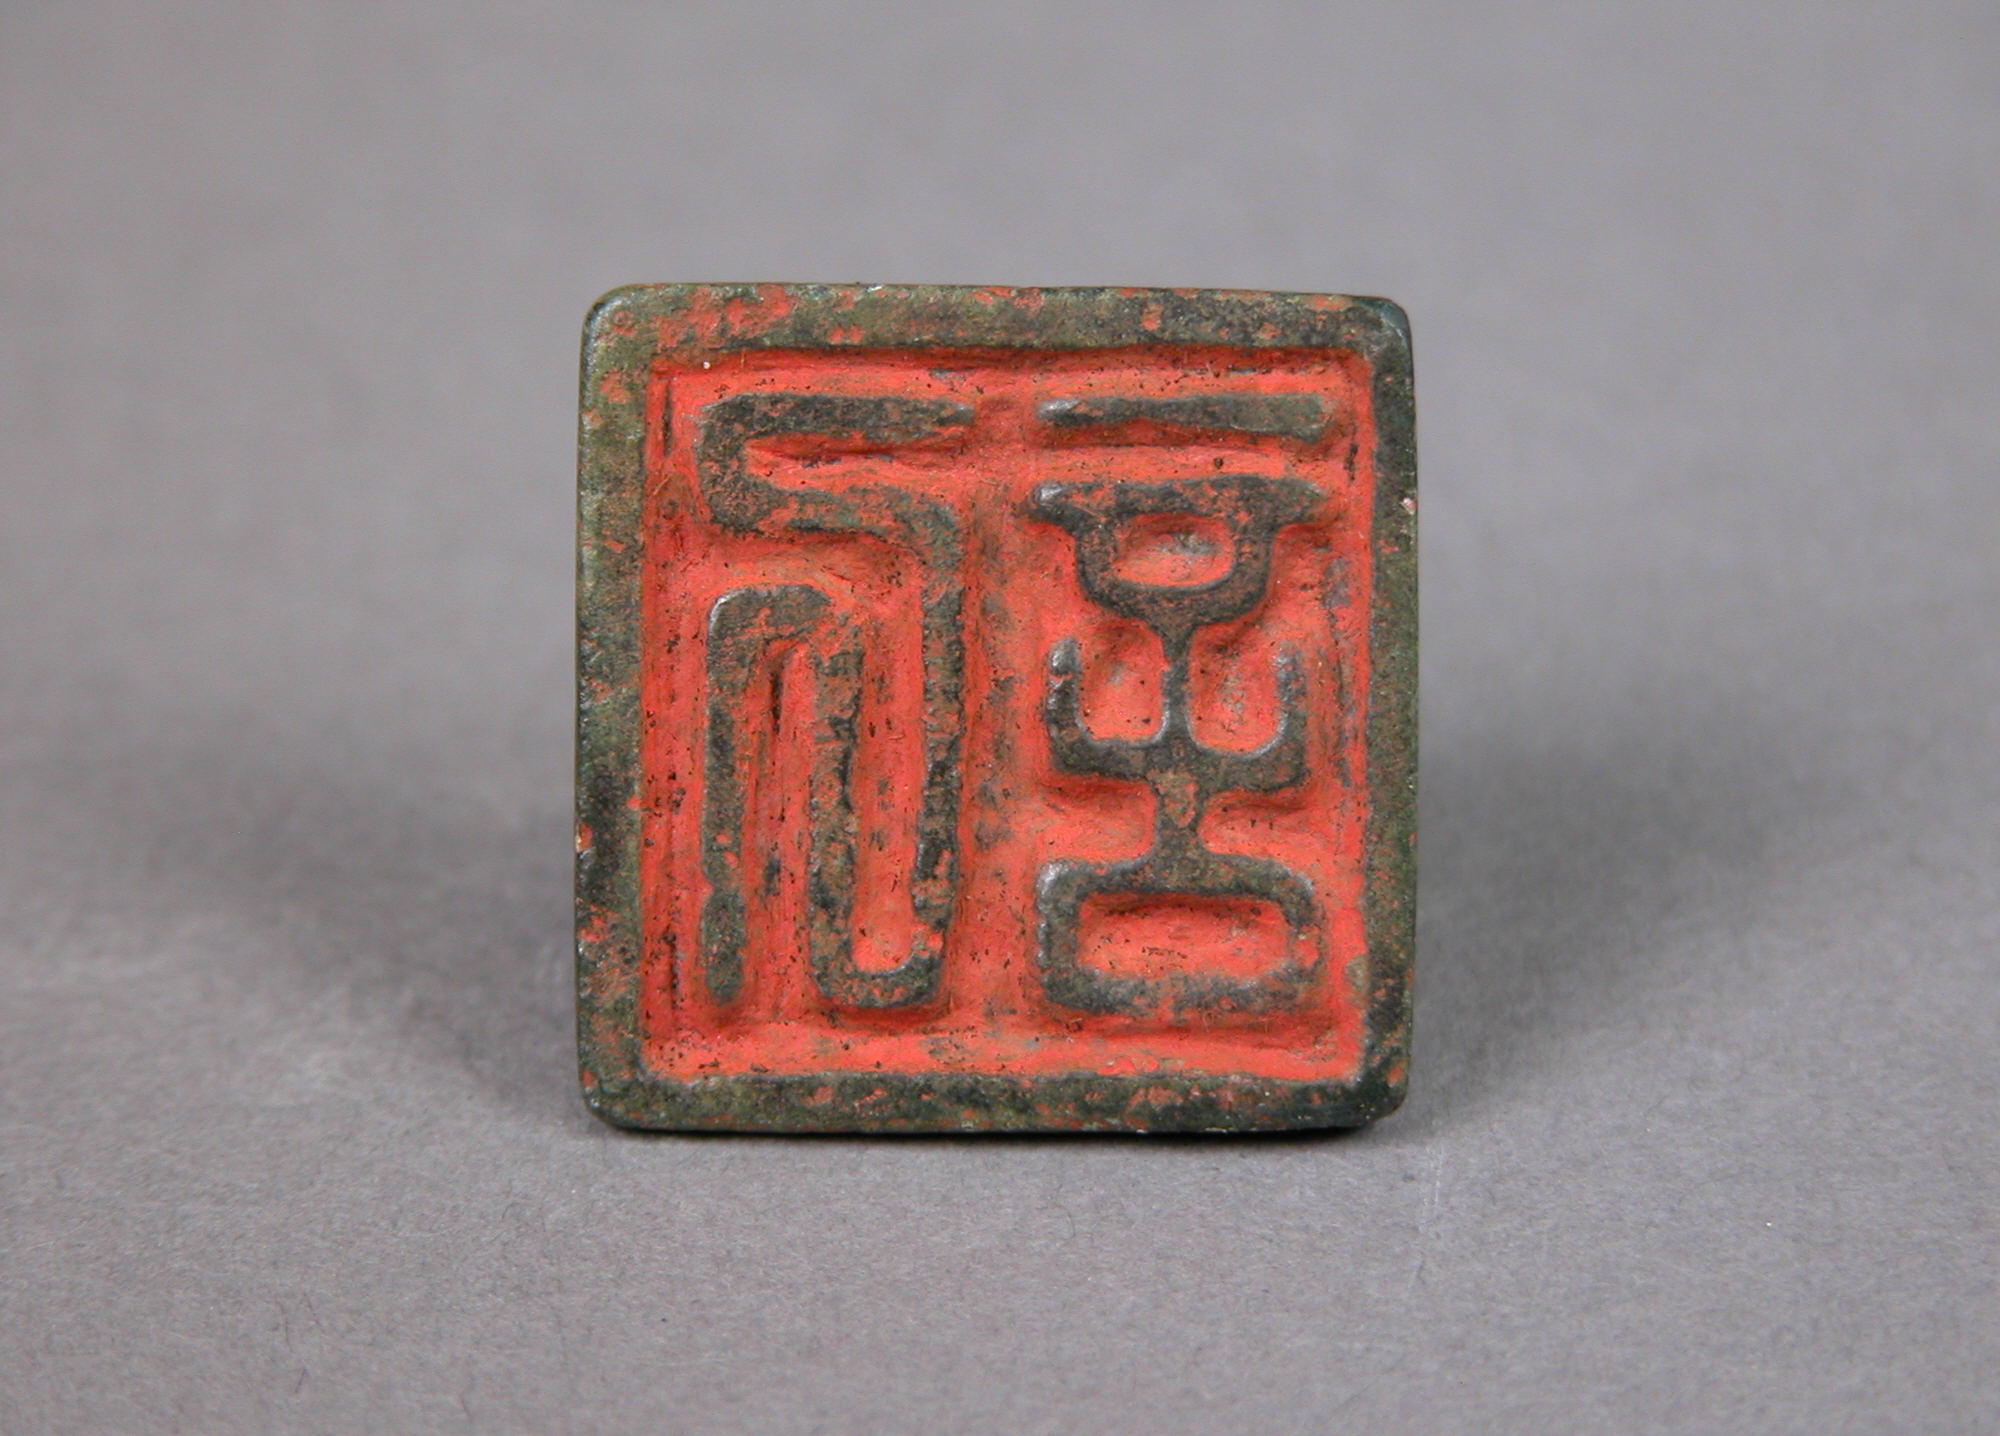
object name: seal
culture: chinese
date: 1300-1644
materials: bronze